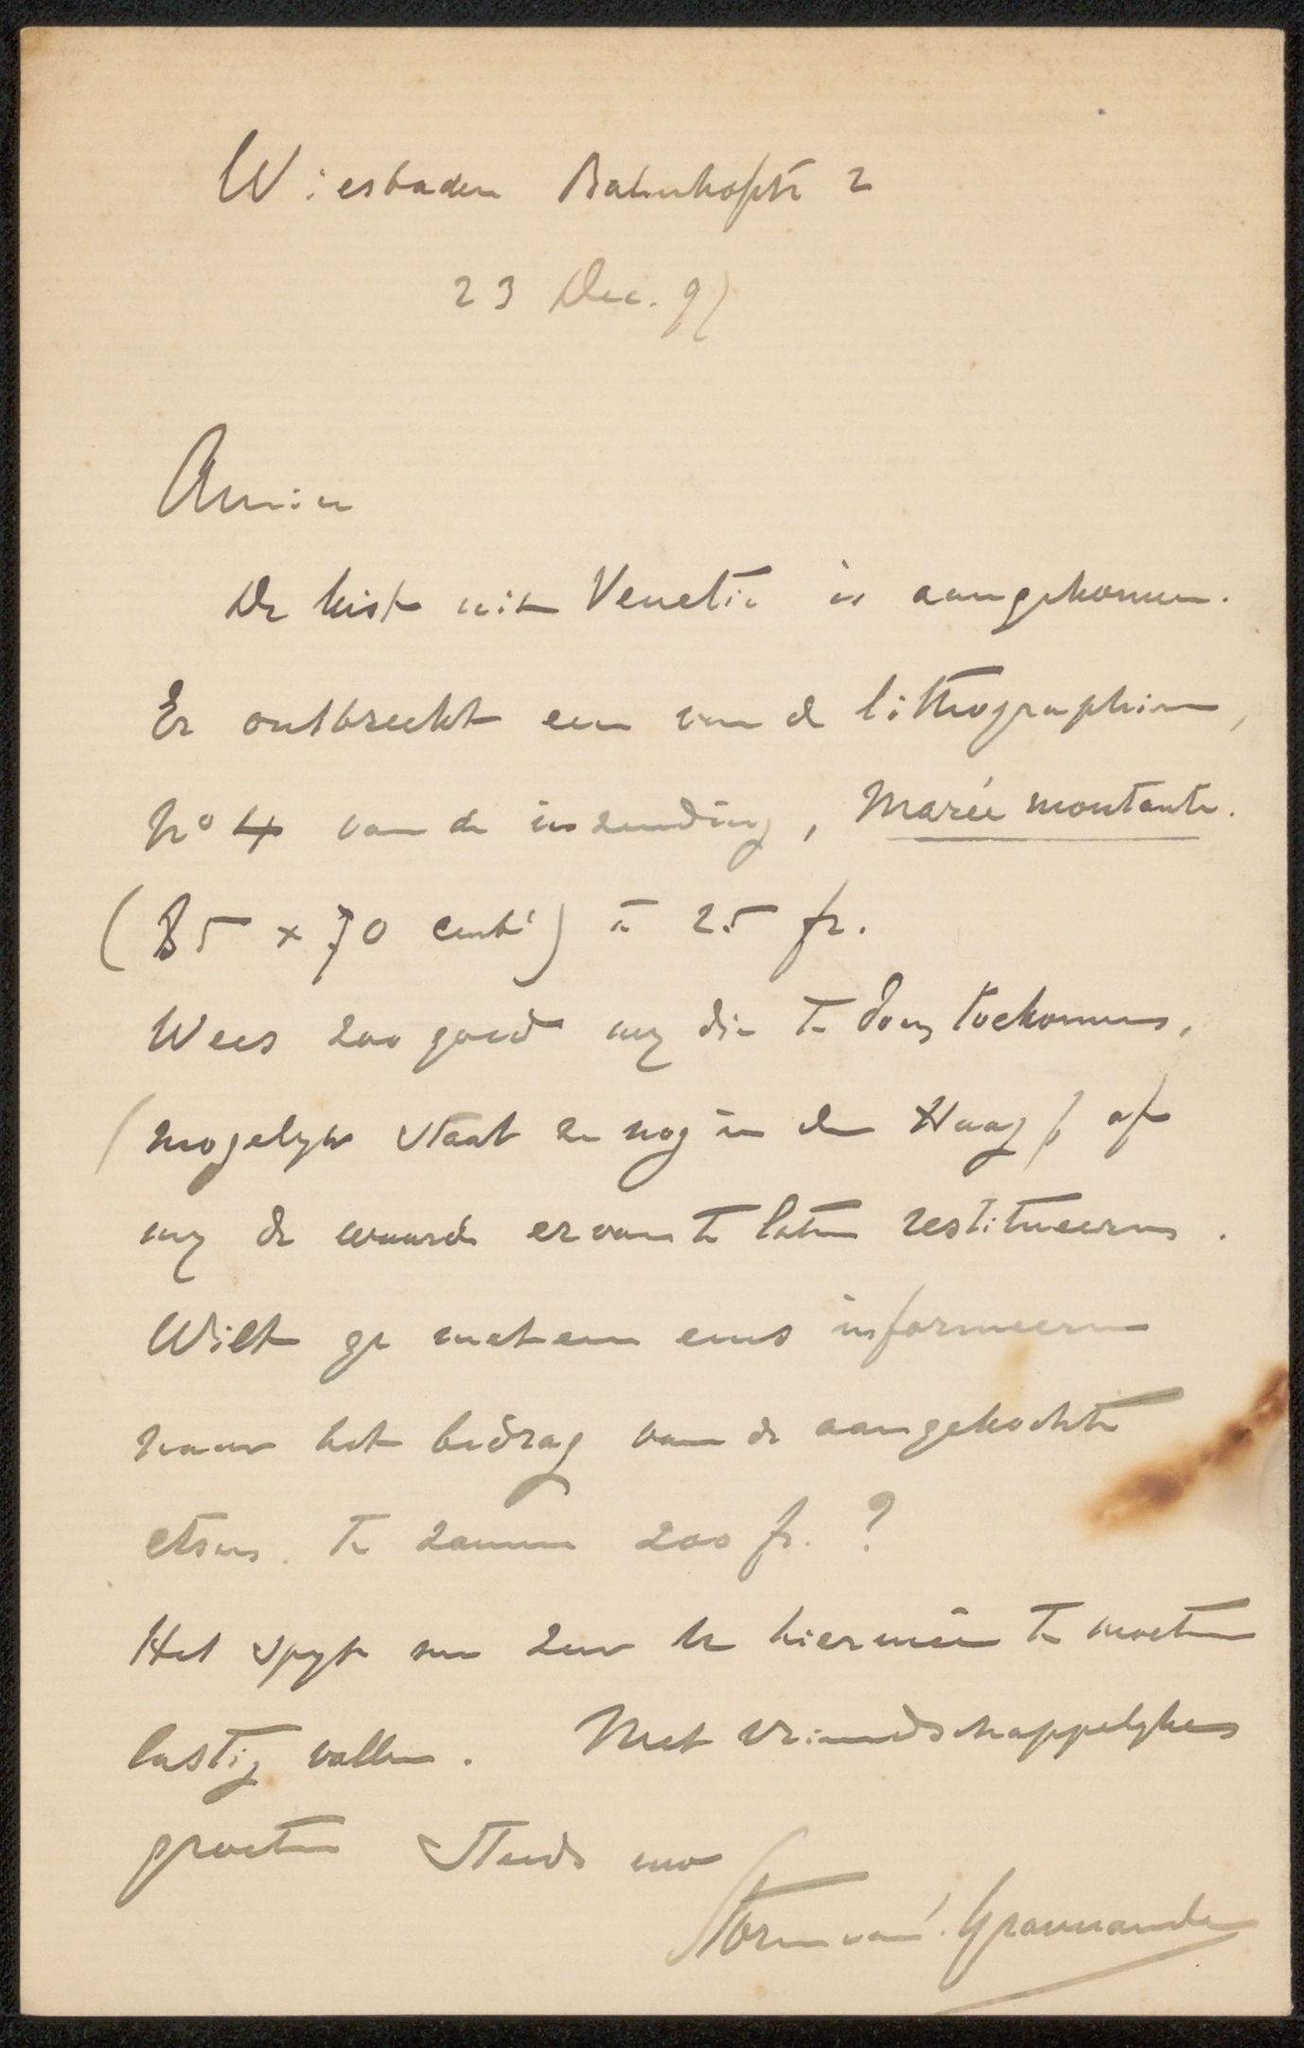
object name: postcard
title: Briefkaart aan Philip Zilcken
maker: carel nicolaas storm van s-gravesande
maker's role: draughtsman, print maker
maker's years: 1841-1924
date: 1897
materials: cardboard, ink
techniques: pen, writing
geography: wiesbaden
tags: painter, philip zilcken, the graphic arts, exhibition ~ art, money, the hague, venice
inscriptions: collector's mark: ‘RPK’